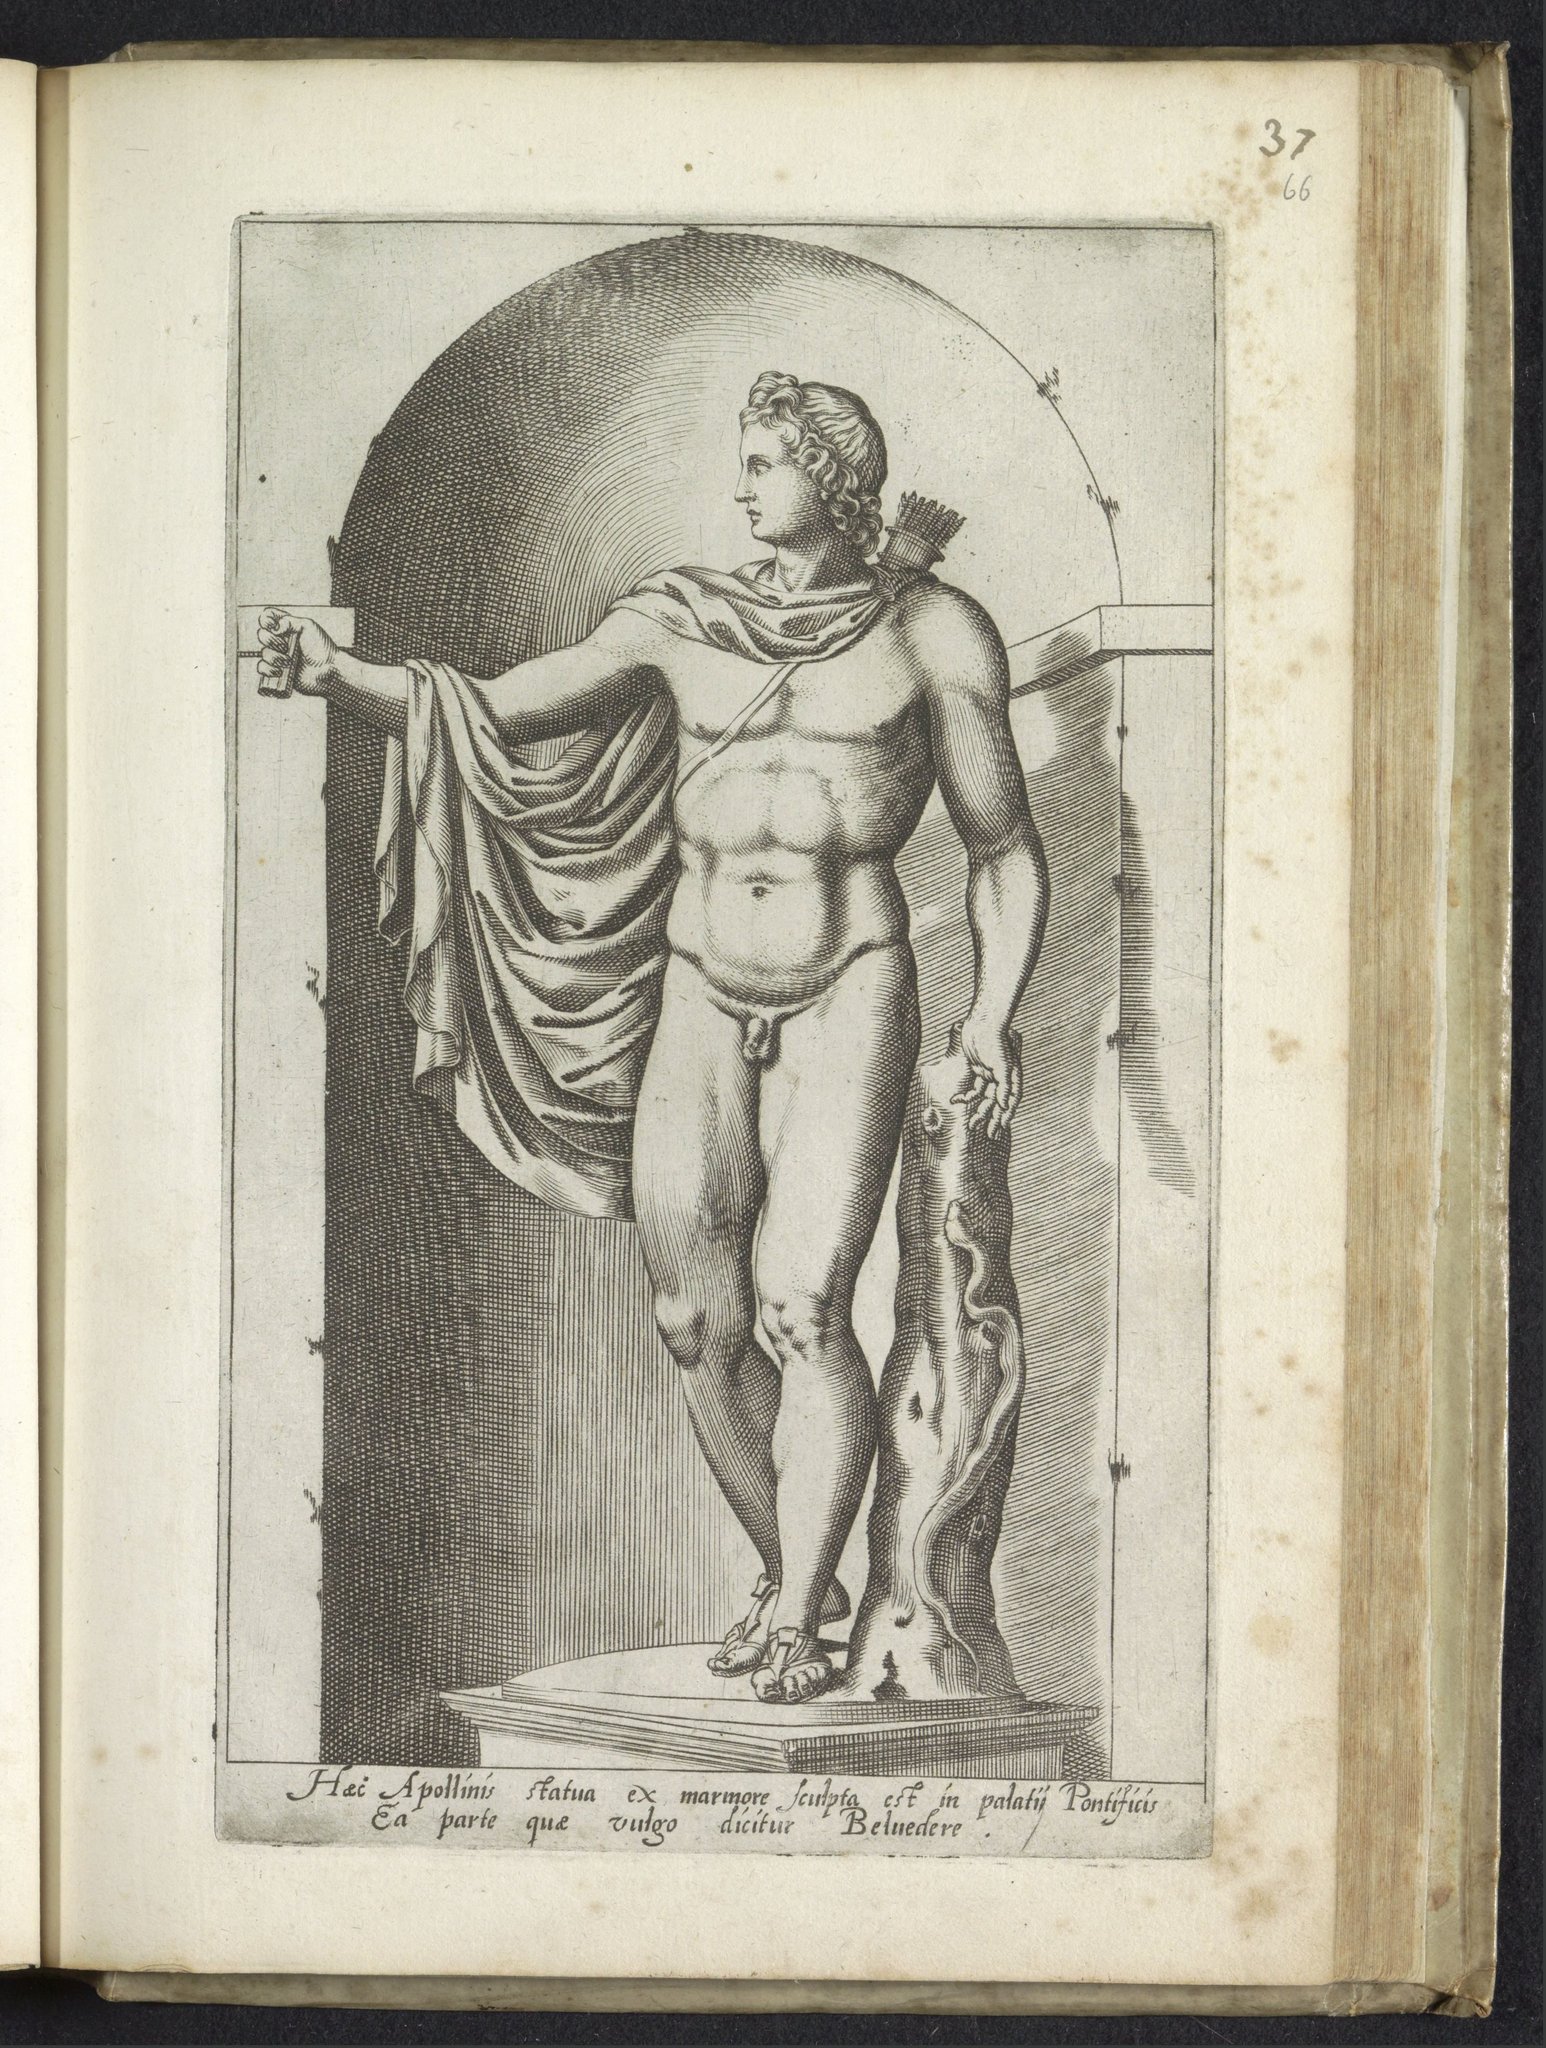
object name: album leaf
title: Antiquarum statuarum urbis Romae quae in publicis locis visuntur icones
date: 1584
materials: paper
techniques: engraving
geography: italy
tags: (story of) apollo (phoebus), piece of sculpture, reproduction of a piece of sculpture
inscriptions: number: ‘37’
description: Naar een antiek beeld in de Vaticaanse Musea te Vaticaanstad. Deze prent maakt deel uit van een set van 79 prenten (+ titelprent) met voorstellingen van antieke sculpturen in Rome.